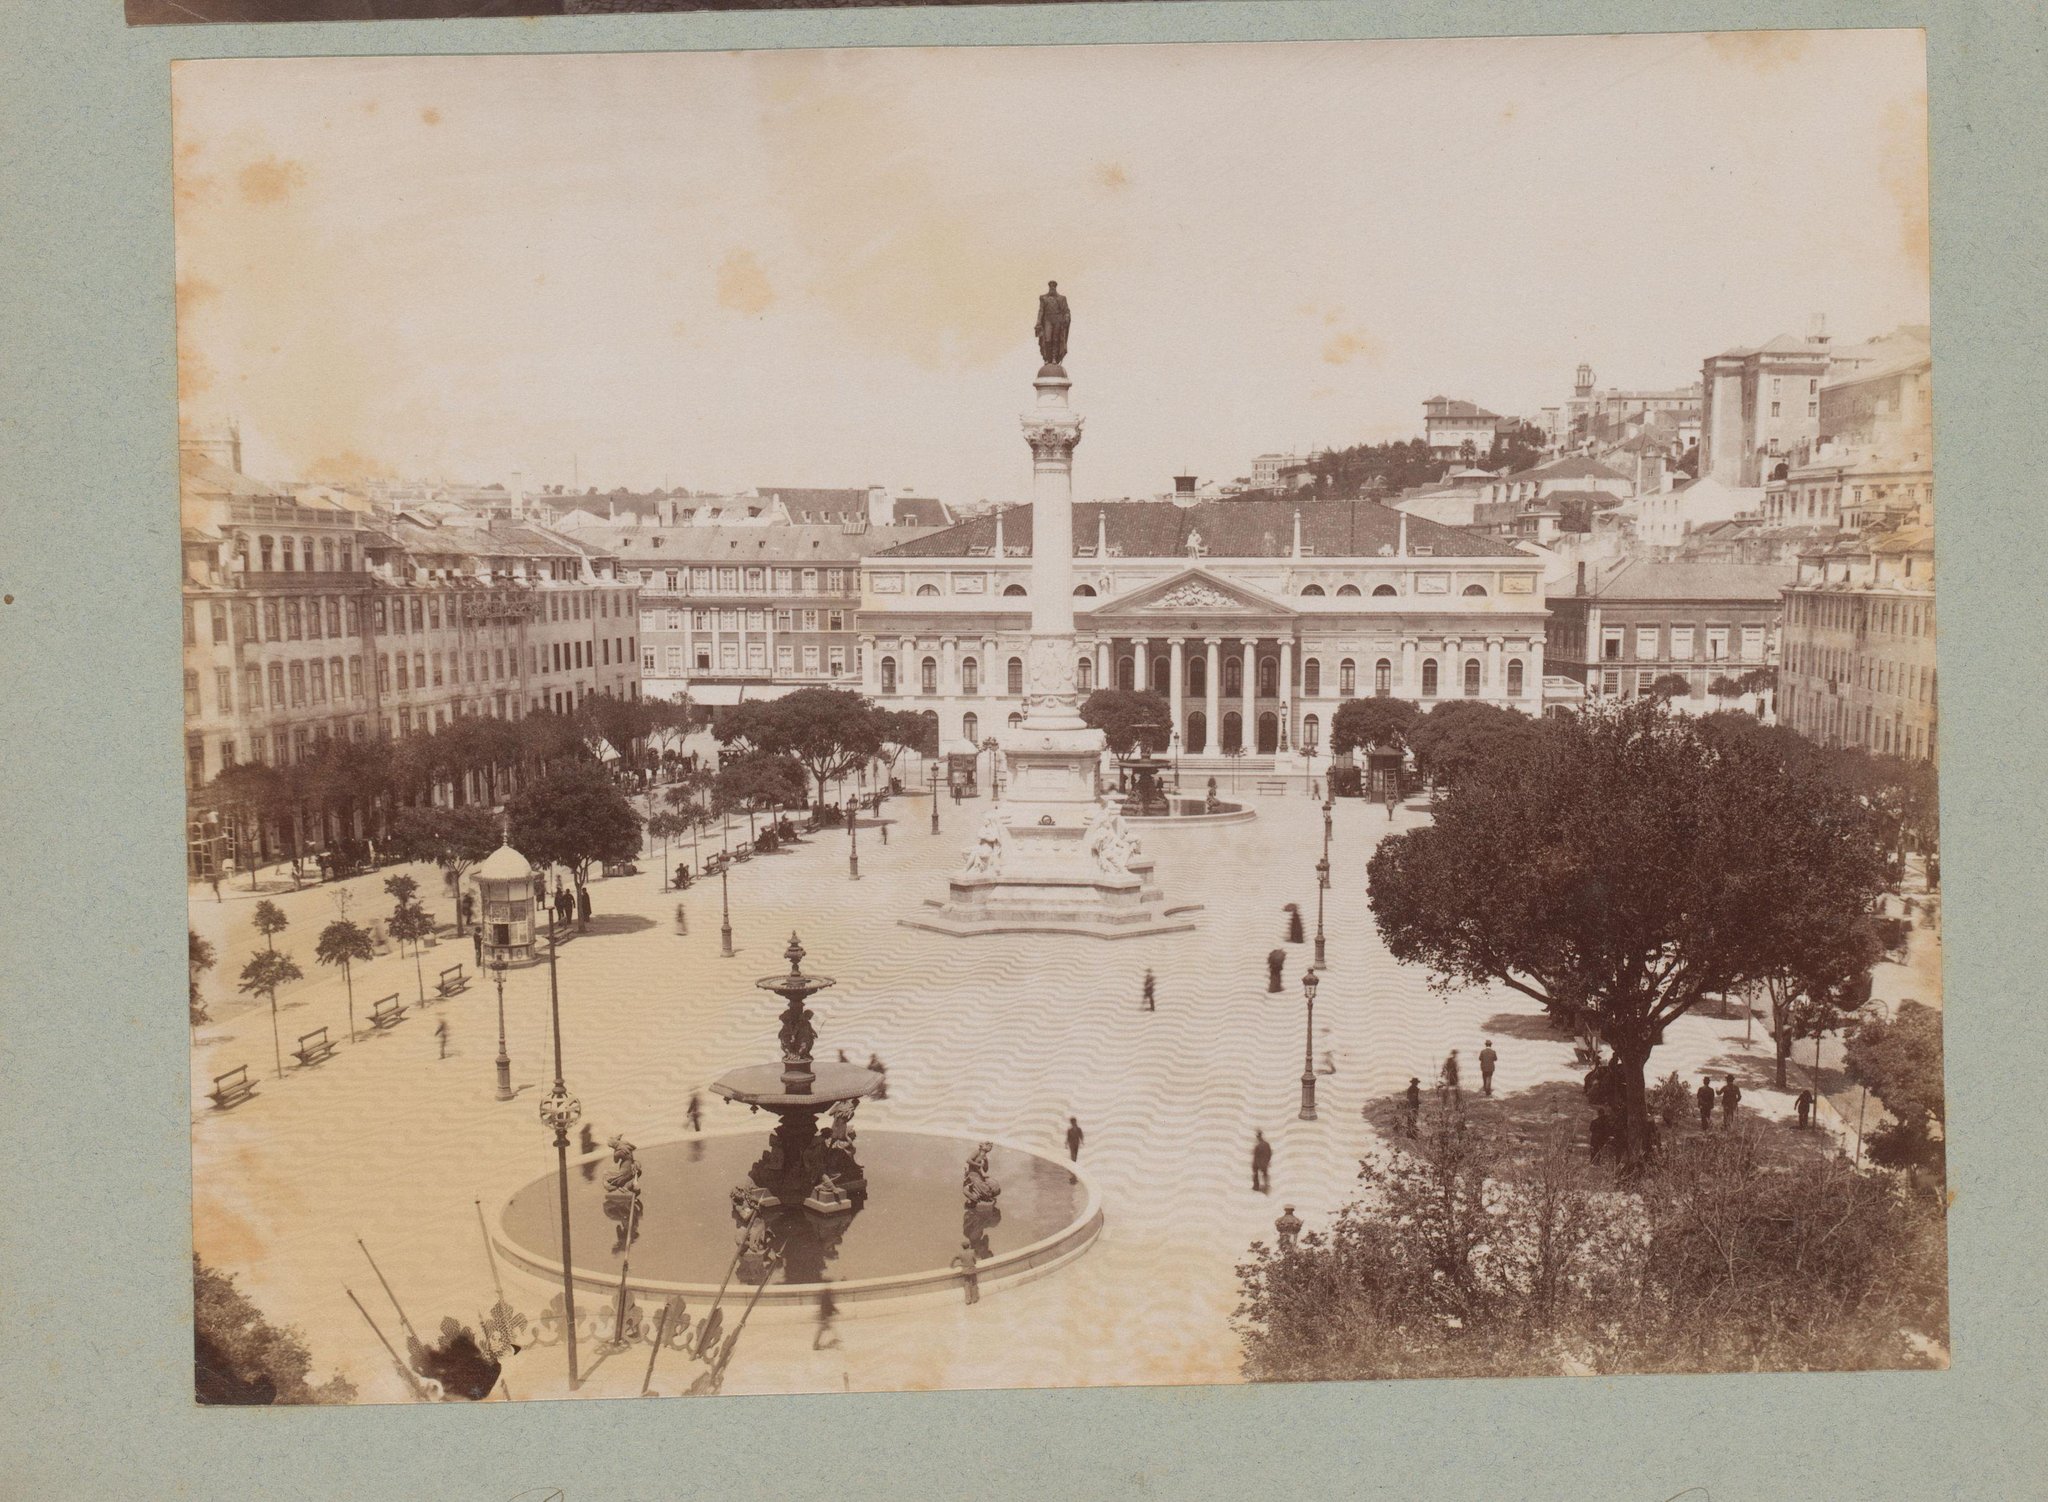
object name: photograph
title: Gezicht op het Pedro IV-plein in Lissabon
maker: Anonymous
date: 1860-1900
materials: cardboard, paper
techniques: albumen print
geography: pedro iv square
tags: square, place, circus, etc.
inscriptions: inscription: ‘(5 Juni - 20 Juni)’